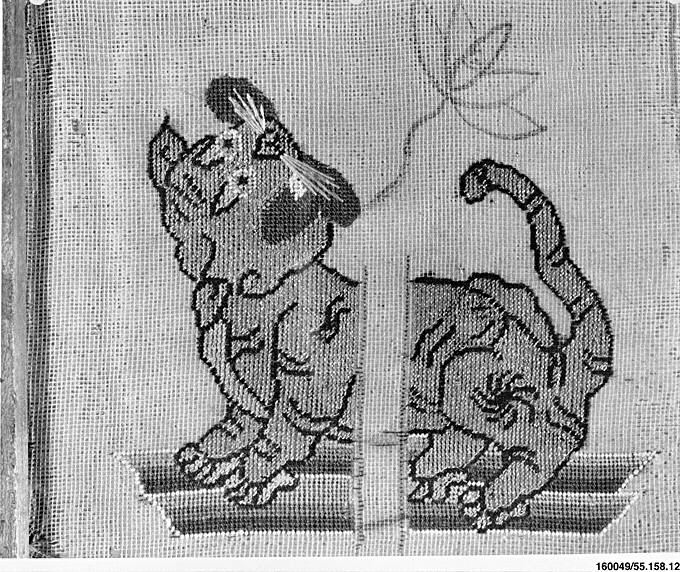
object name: appliqué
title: Applique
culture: chinese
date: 1867-1933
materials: metal thread, silk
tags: animals